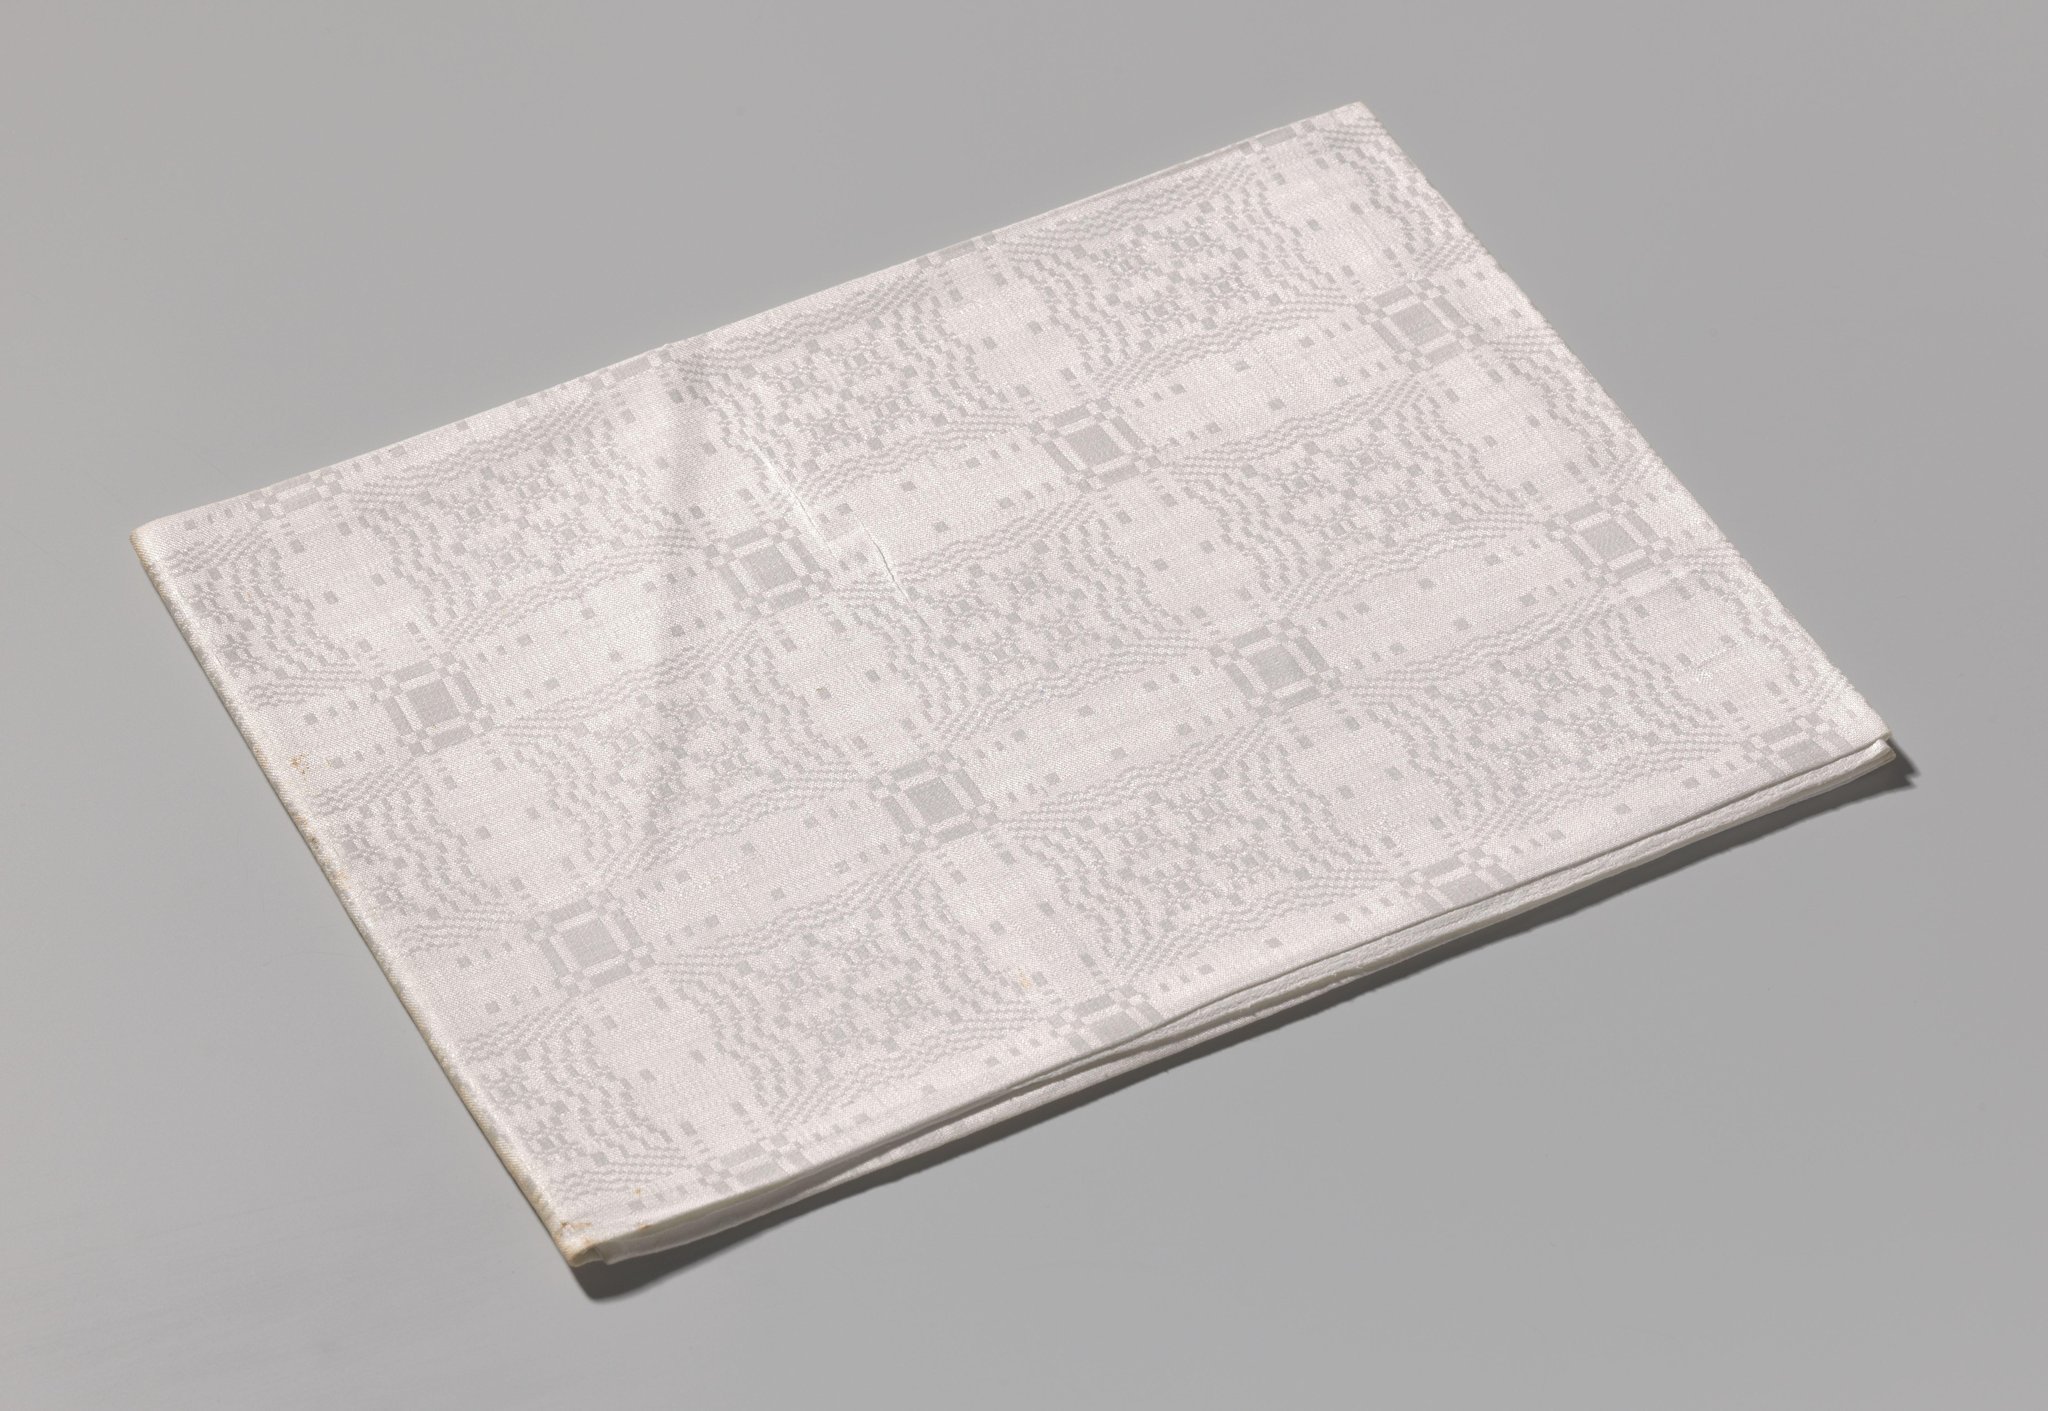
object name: napkin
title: Servet van linnen met pellenpatroon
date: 1400-1950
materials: linen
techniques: peeled fabric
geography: northern netherlands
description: Wit linnendamasten servet met pellenpatroon, merk kroon IS en 96.